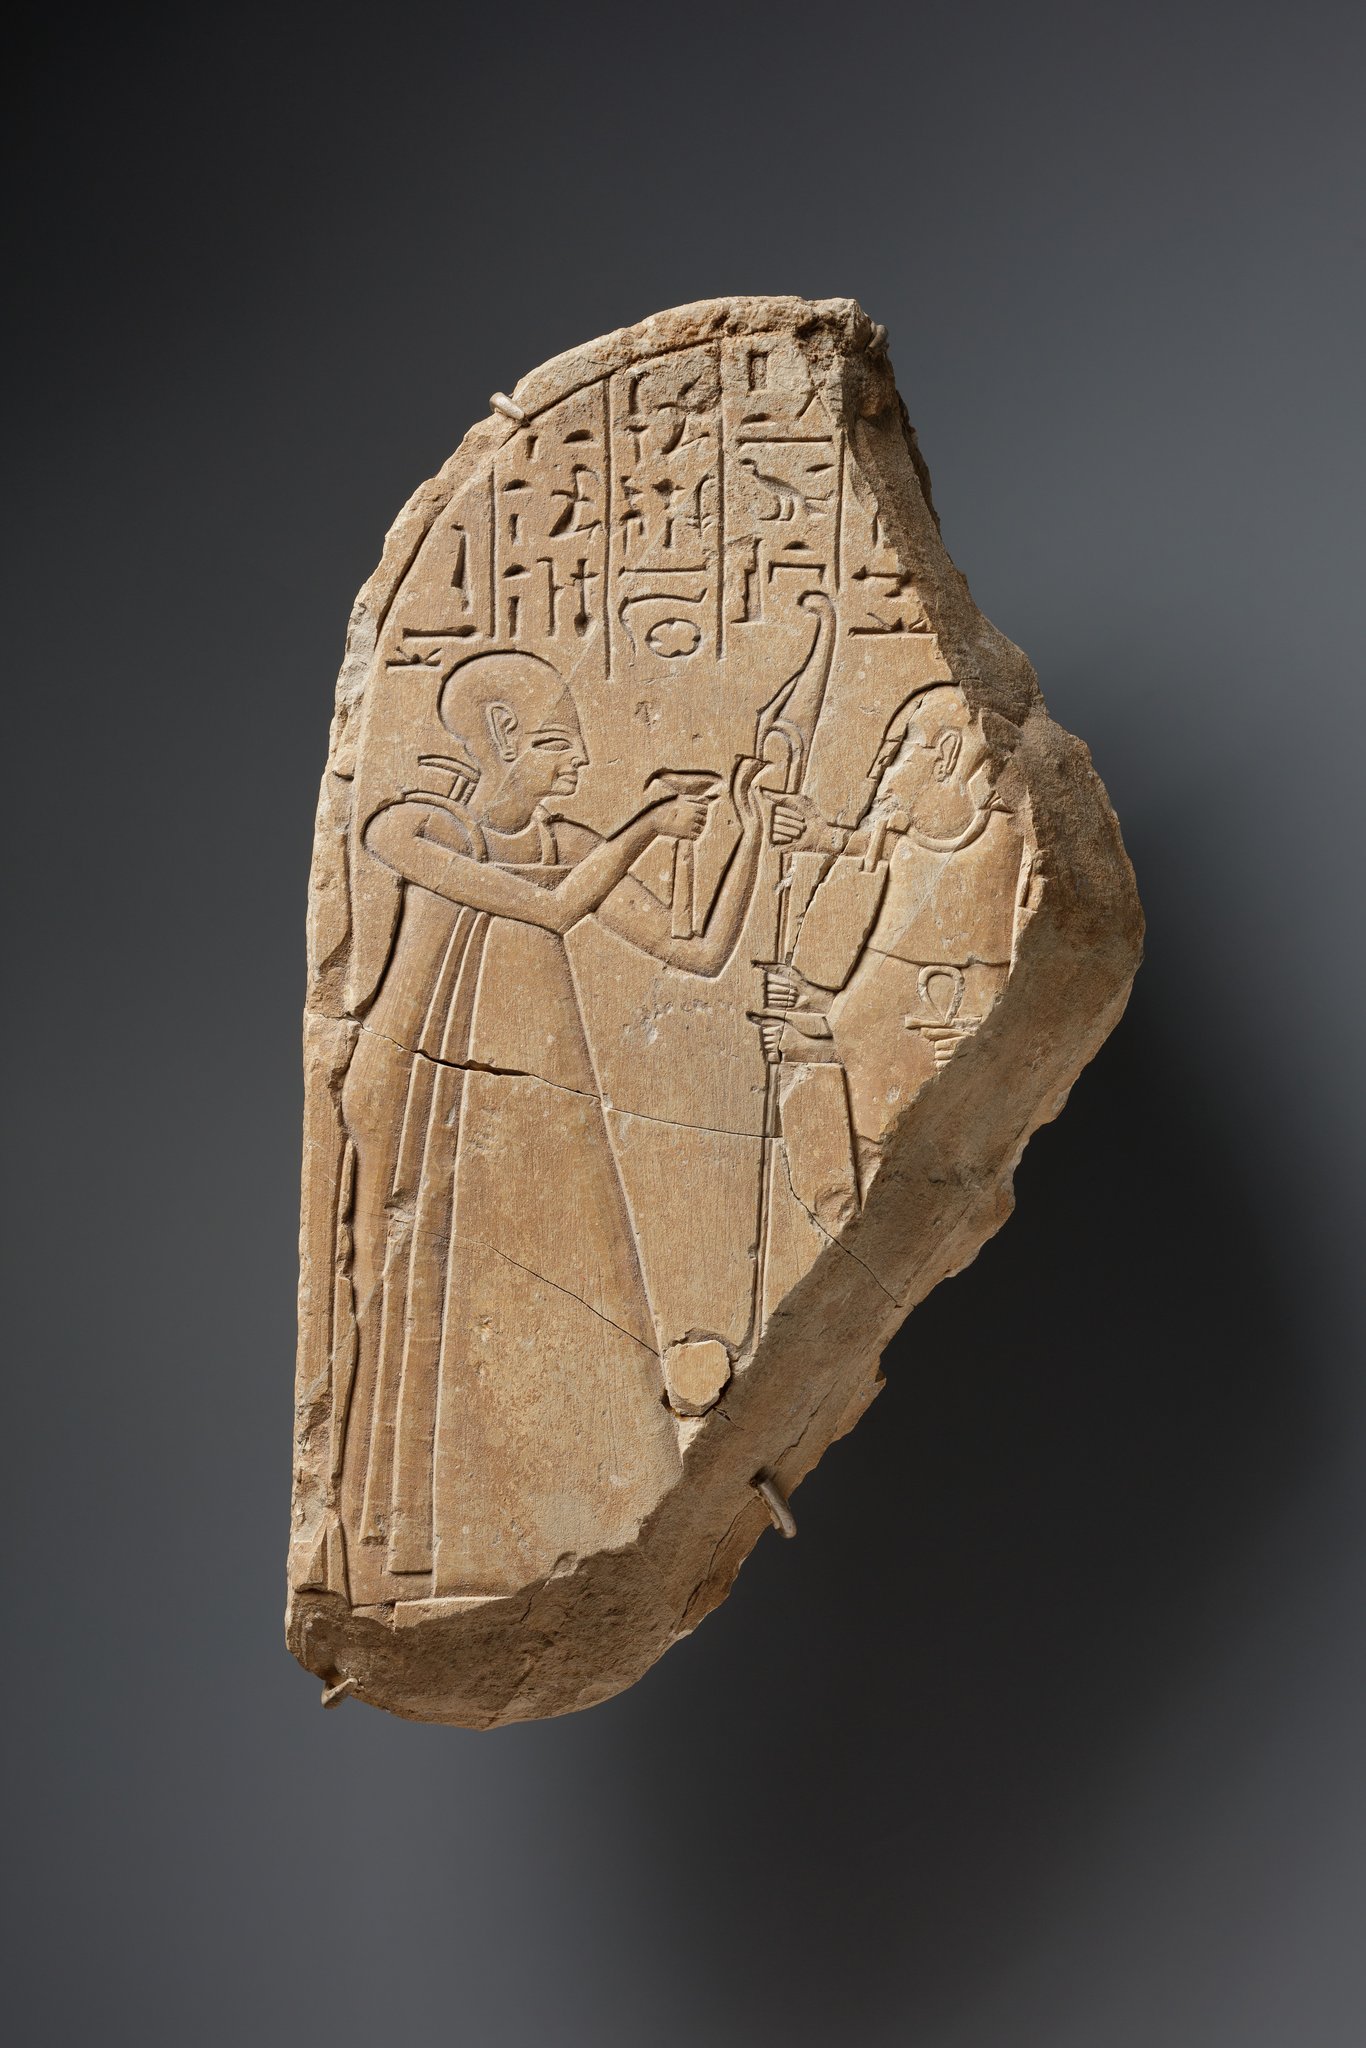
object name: stela, vizier neferrenpet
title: Stela of the Vizier Neferrenpet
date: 1279-1213 BCE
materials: limestone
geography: egypt